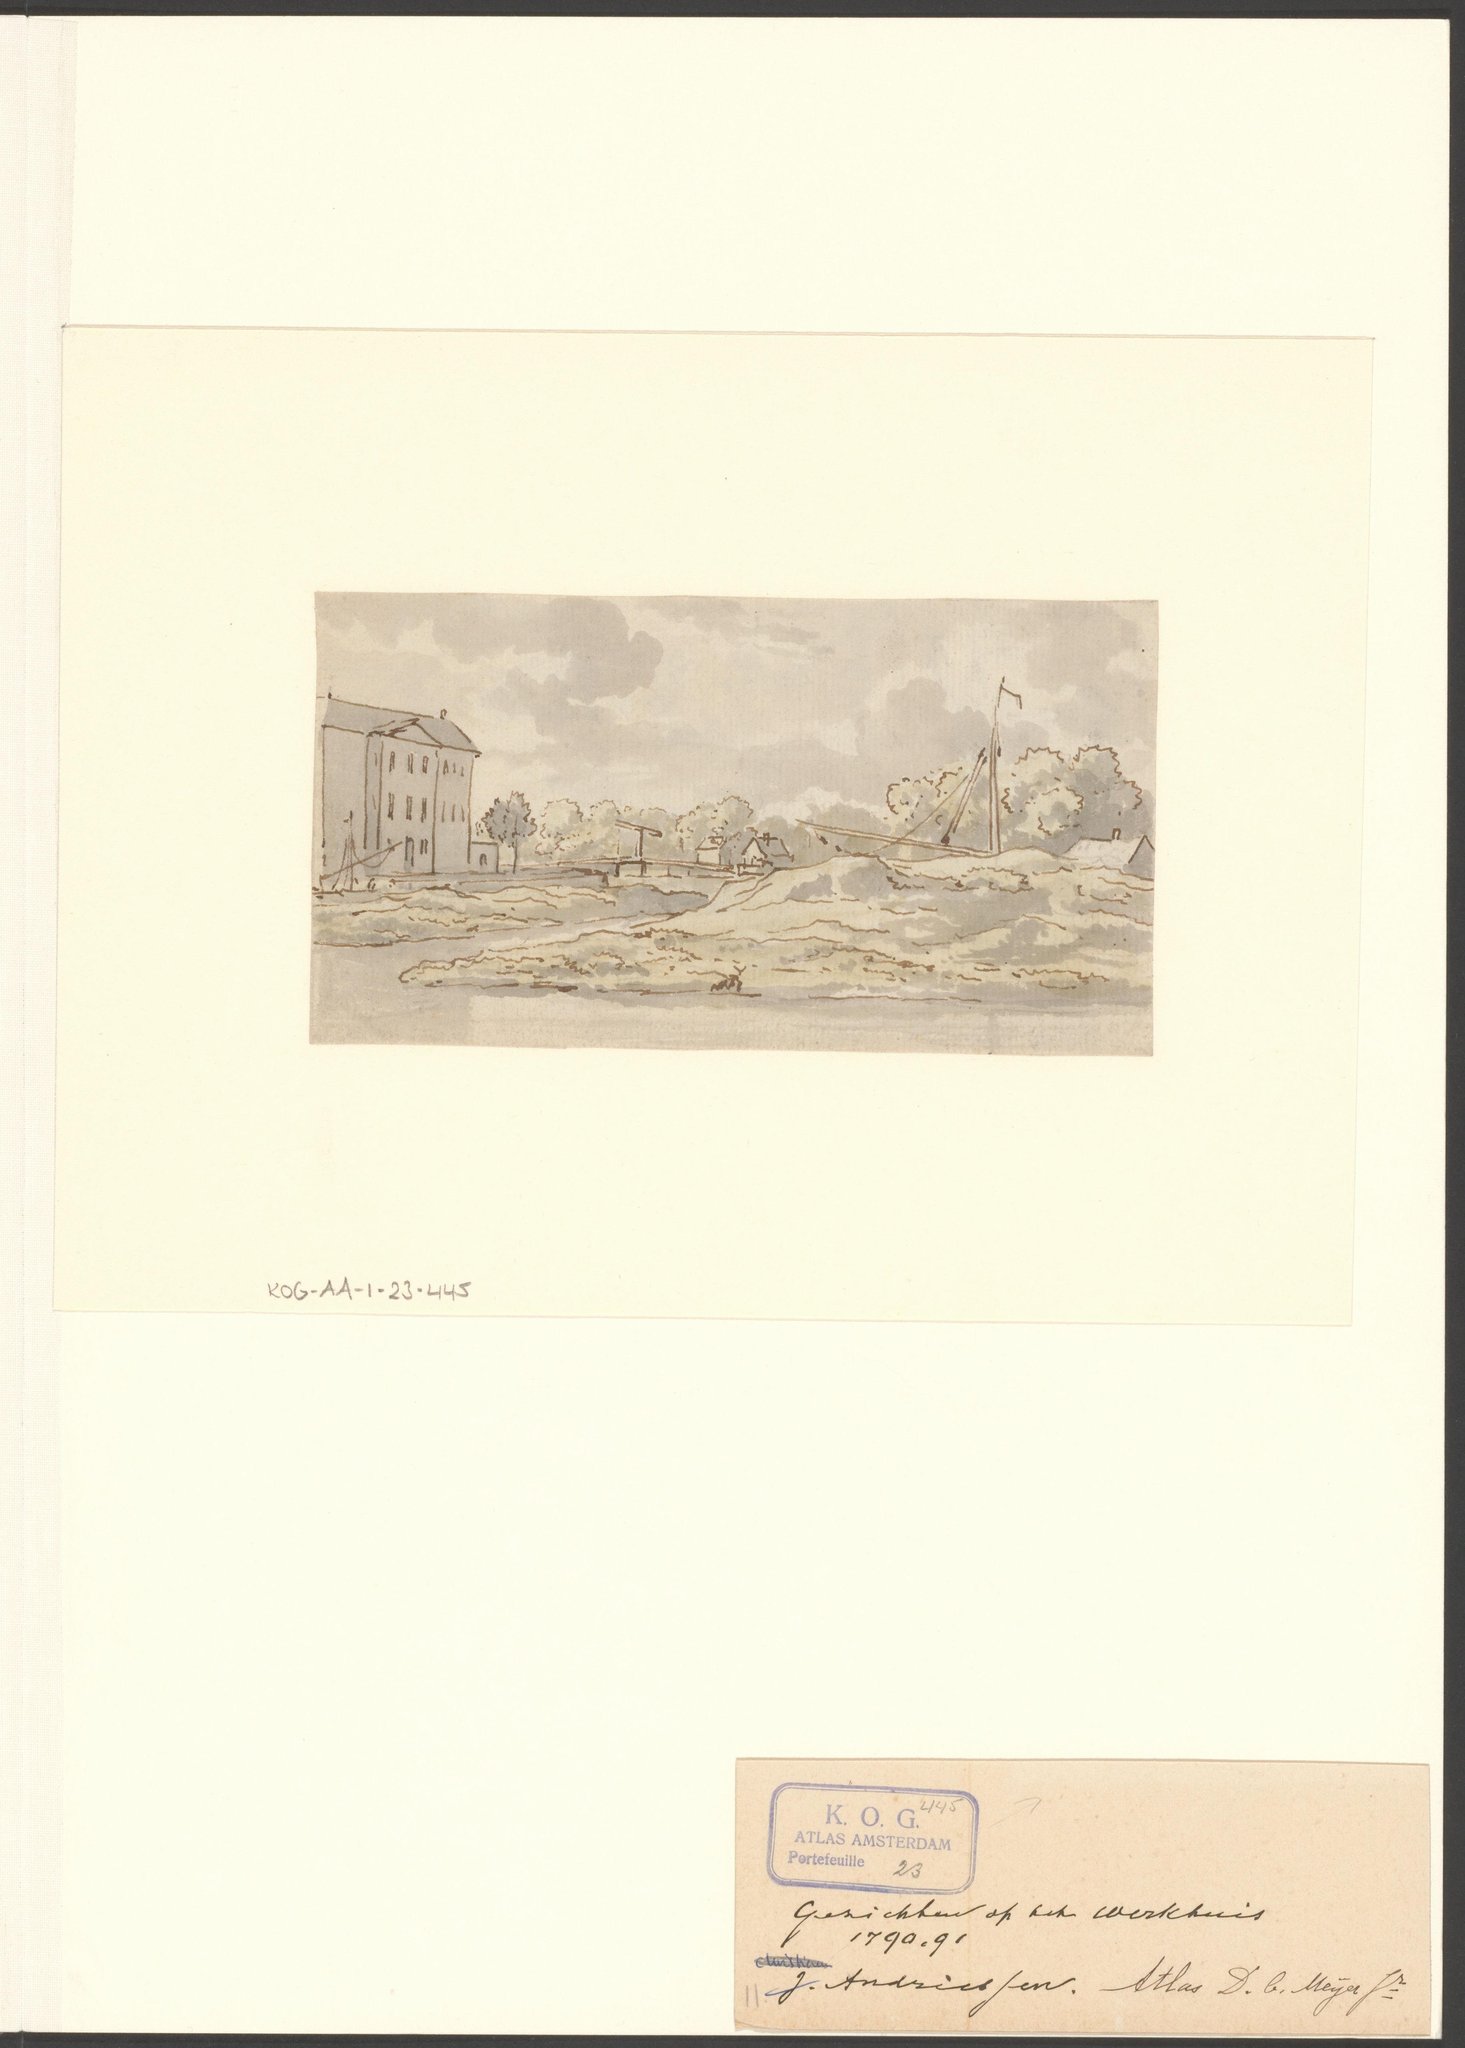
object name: drawing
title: Gezicht op het Nieuwe Werkhuis, gezien vanaf het Roeterseiland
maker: jurriaan andriessen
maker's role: draughtsman, painter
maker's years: 1742-1819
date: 1790-1791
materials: ink, paper, pencil, watercolor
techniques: brush, pen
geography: amsterdam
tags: city-view in general; 'veduta', river, specialized institutions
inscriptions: inscription: ‘Gezichten op het werkhuis / 1790/91 / J. Andriessen Atlas D.C. Meijer Jr’, collector's mark: ‘23’ Lugt 1641b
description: Onderwerpsrubriek binnen de Atlas Amsterdam: Handvesten, Keuren, enz.; Rechtswezen (incl. gevangenissen, enz.).